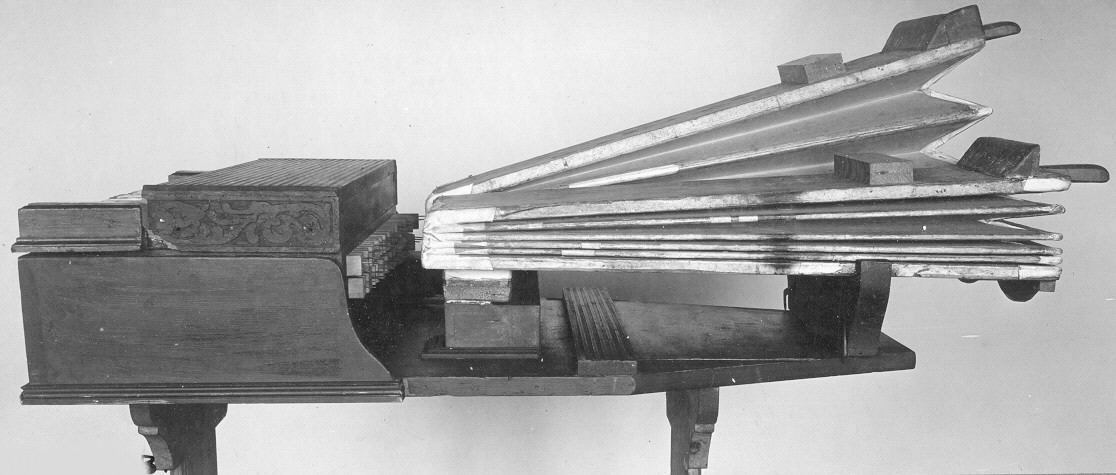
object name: regal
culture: german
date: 1720-1740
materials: wood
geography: germany